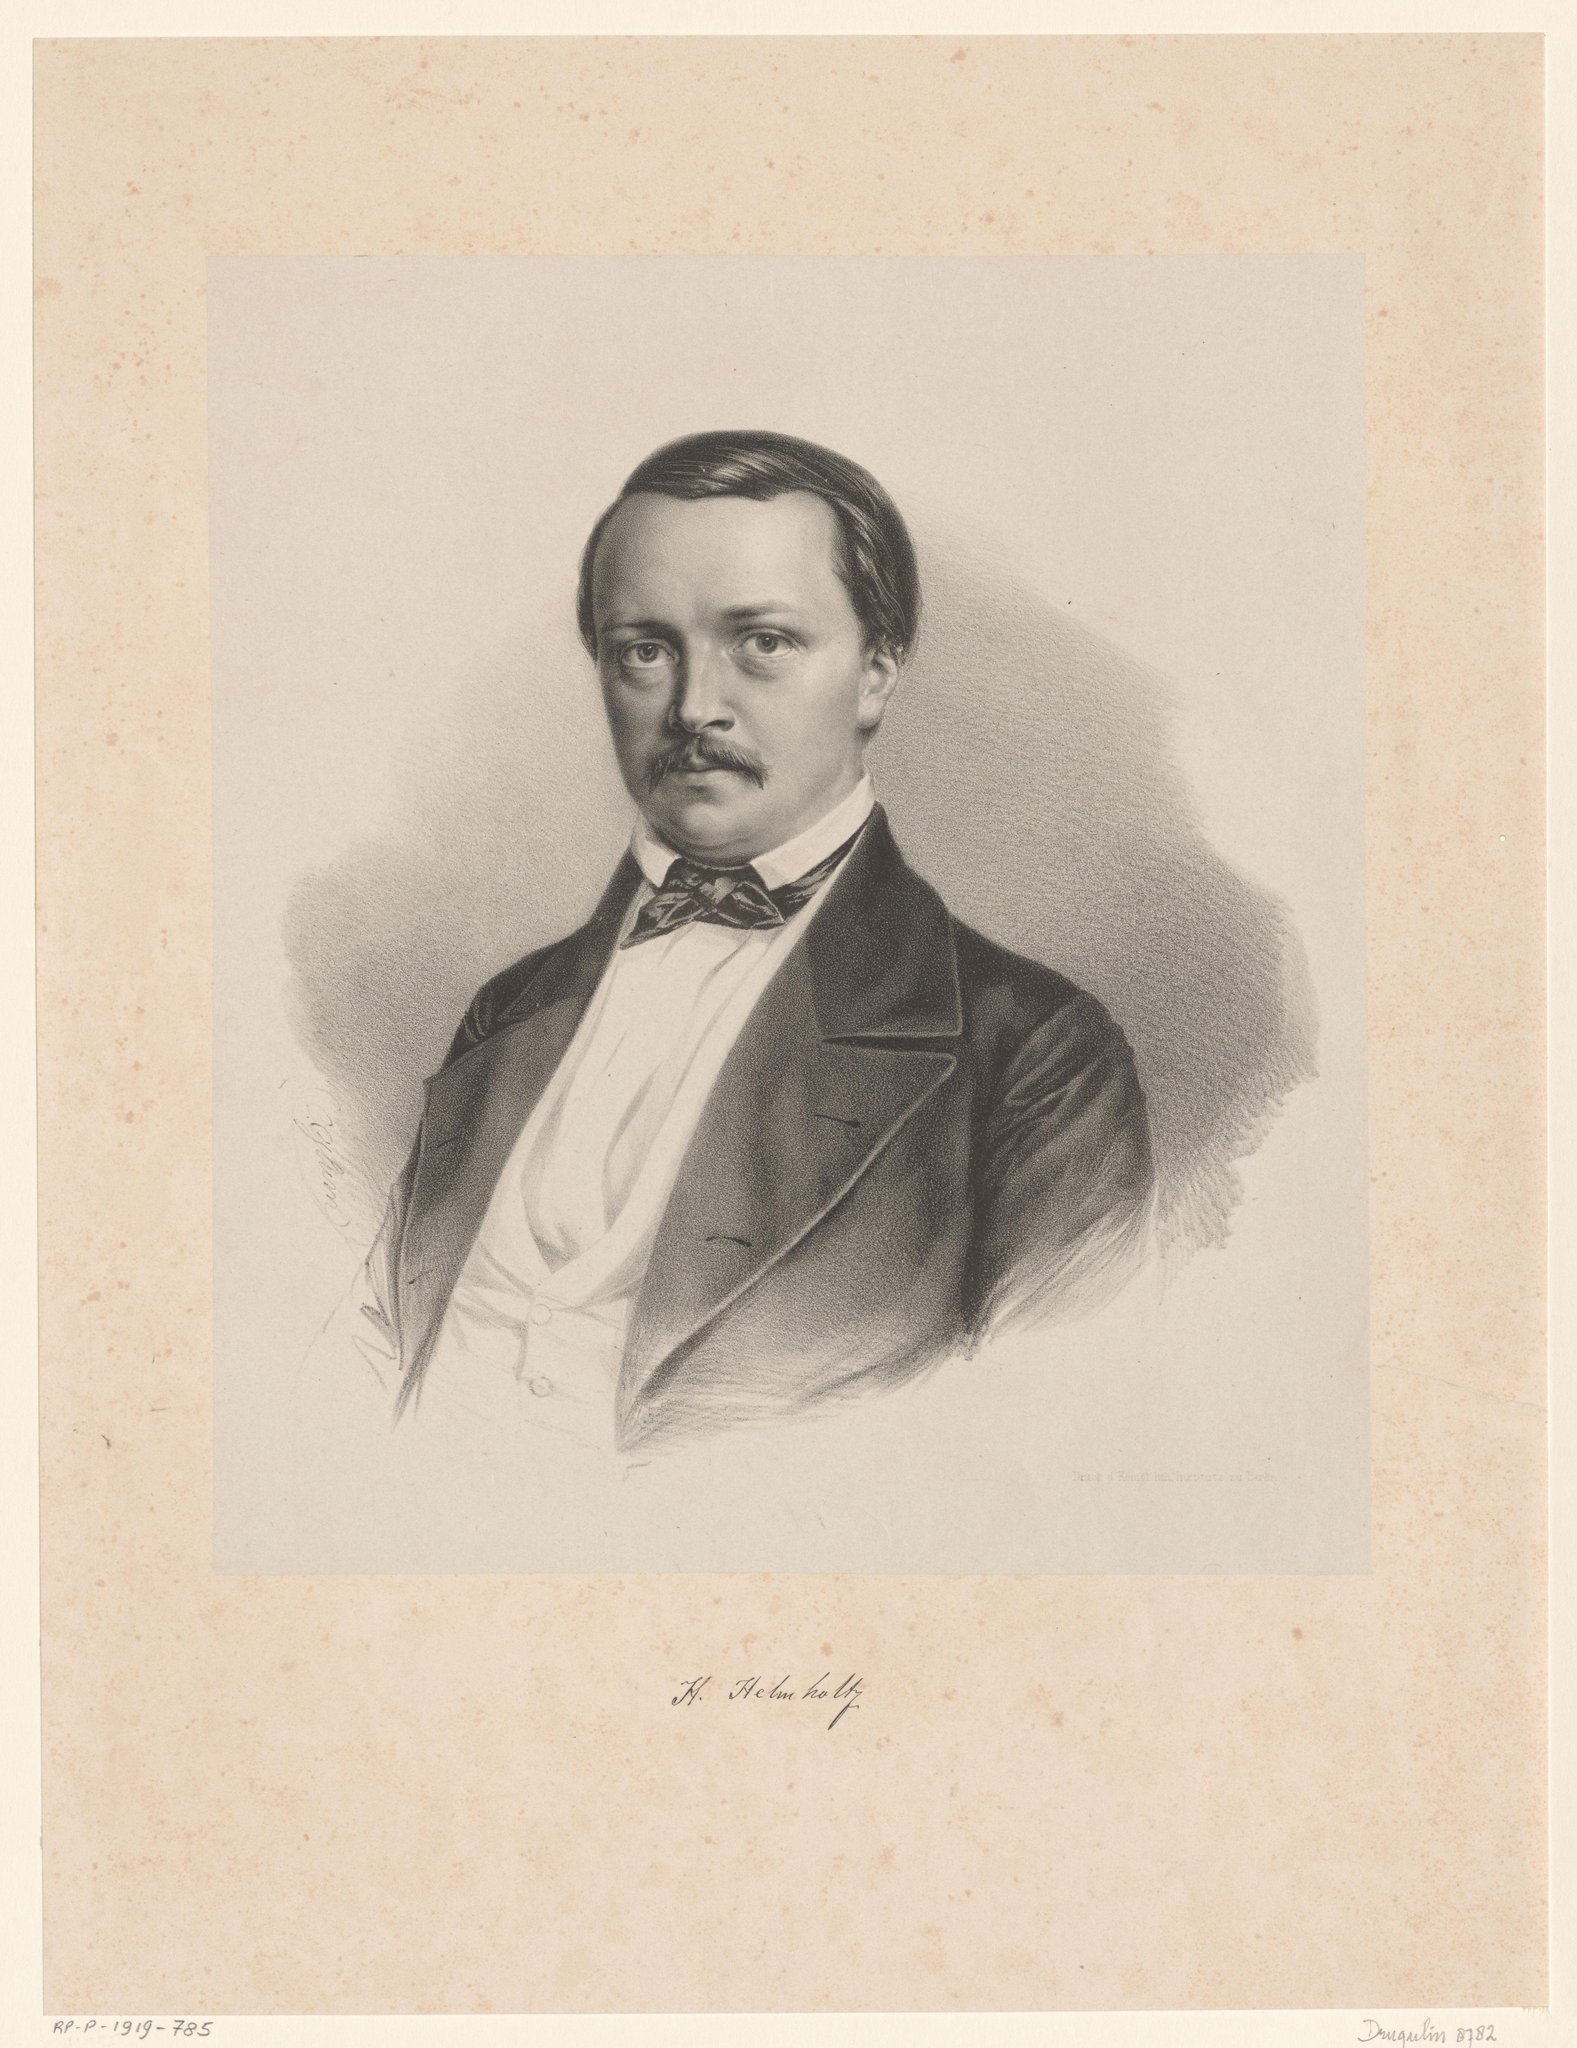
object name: print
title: Portret van Hermann Ludwig Ferdinand von Helmhotz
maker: Anonymous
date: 1850-1861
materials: paper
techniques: lithograph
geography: berlin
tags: historical persons, physician, doctor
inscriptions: collector's mark: Lugt 2228, collector's mark: ‘Kunst: U: M[...] von L. Meder in Heidelberg’